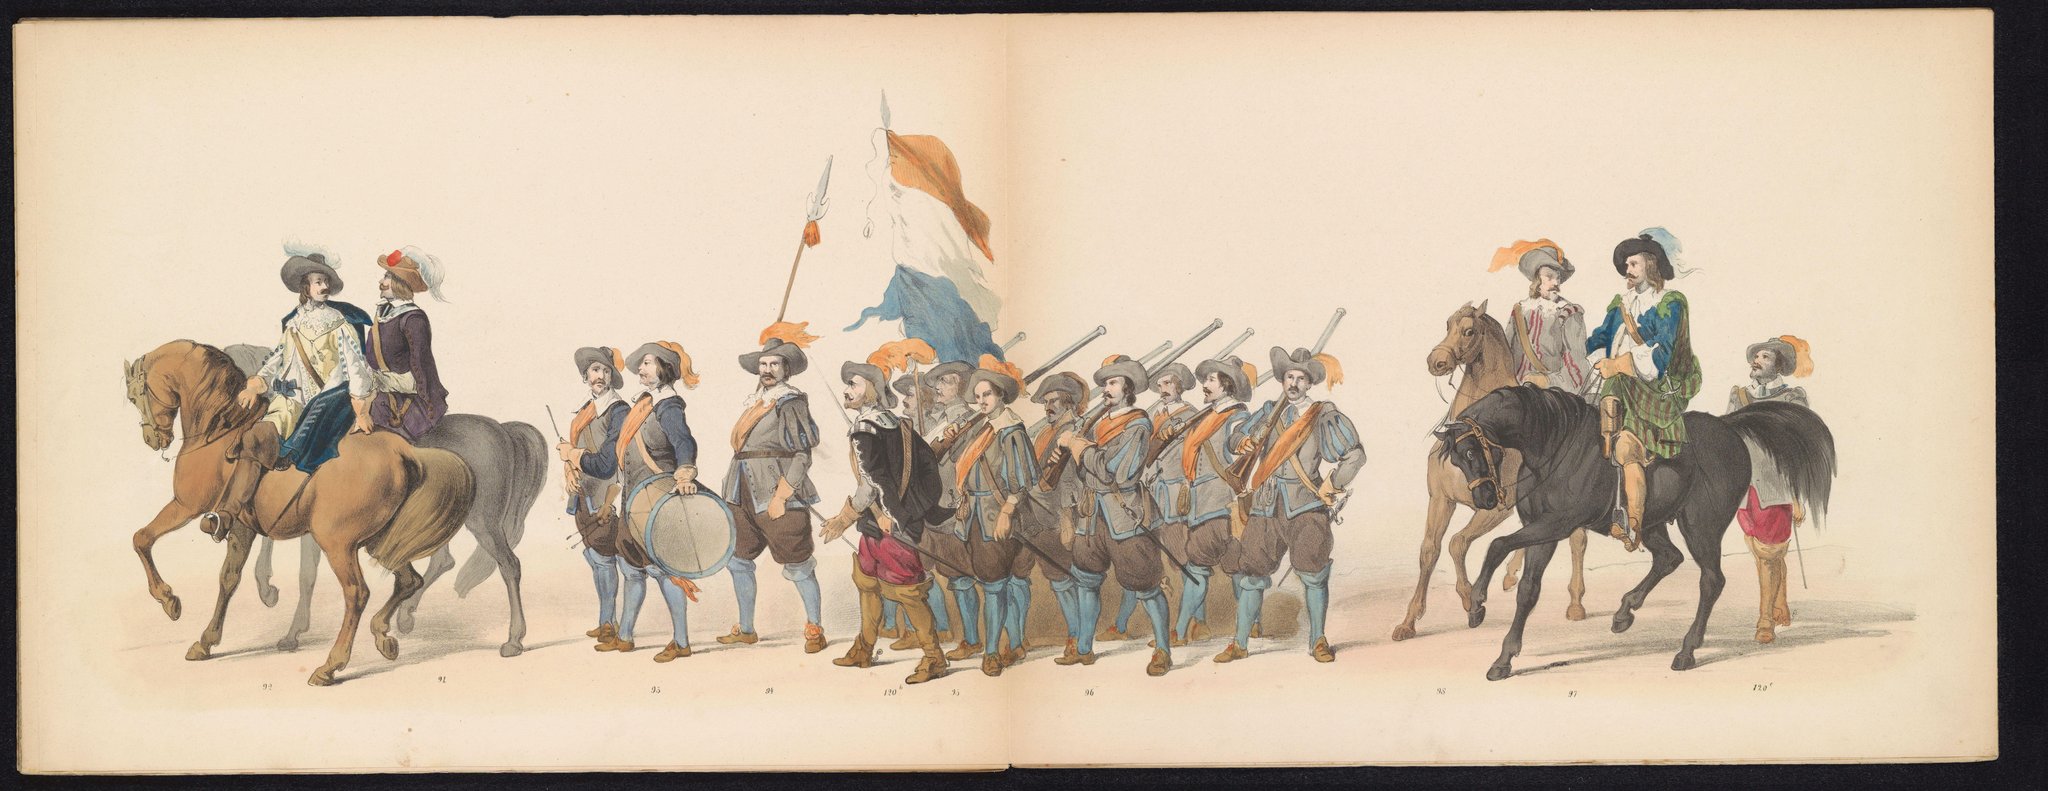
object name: print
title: Intogt van Frederik Hendrik in 's Hertogenbosch in 1629 : gecostumeerde voorstelling door de H.H. studenten der Leydsche Hoogeschool den XI Junij van het jaar 1850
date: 1850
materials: paper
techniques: lithograph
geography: the hague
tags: delft, frederick henry (prince of orange), students' pageant, costumes used in pageants, leiden, den bosch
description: Historische gekostumeerde optocht van de studenten van de Leidse Hogeschool op 11 juni 1850. De optocht verbeeldt de intocht van Frederik Hendrik te Den Bosch in 1629. Tiende plaat met de groepen genummerd 91-98. Onderdeel van de serie van dertien aanelkaar geplakte bladen.